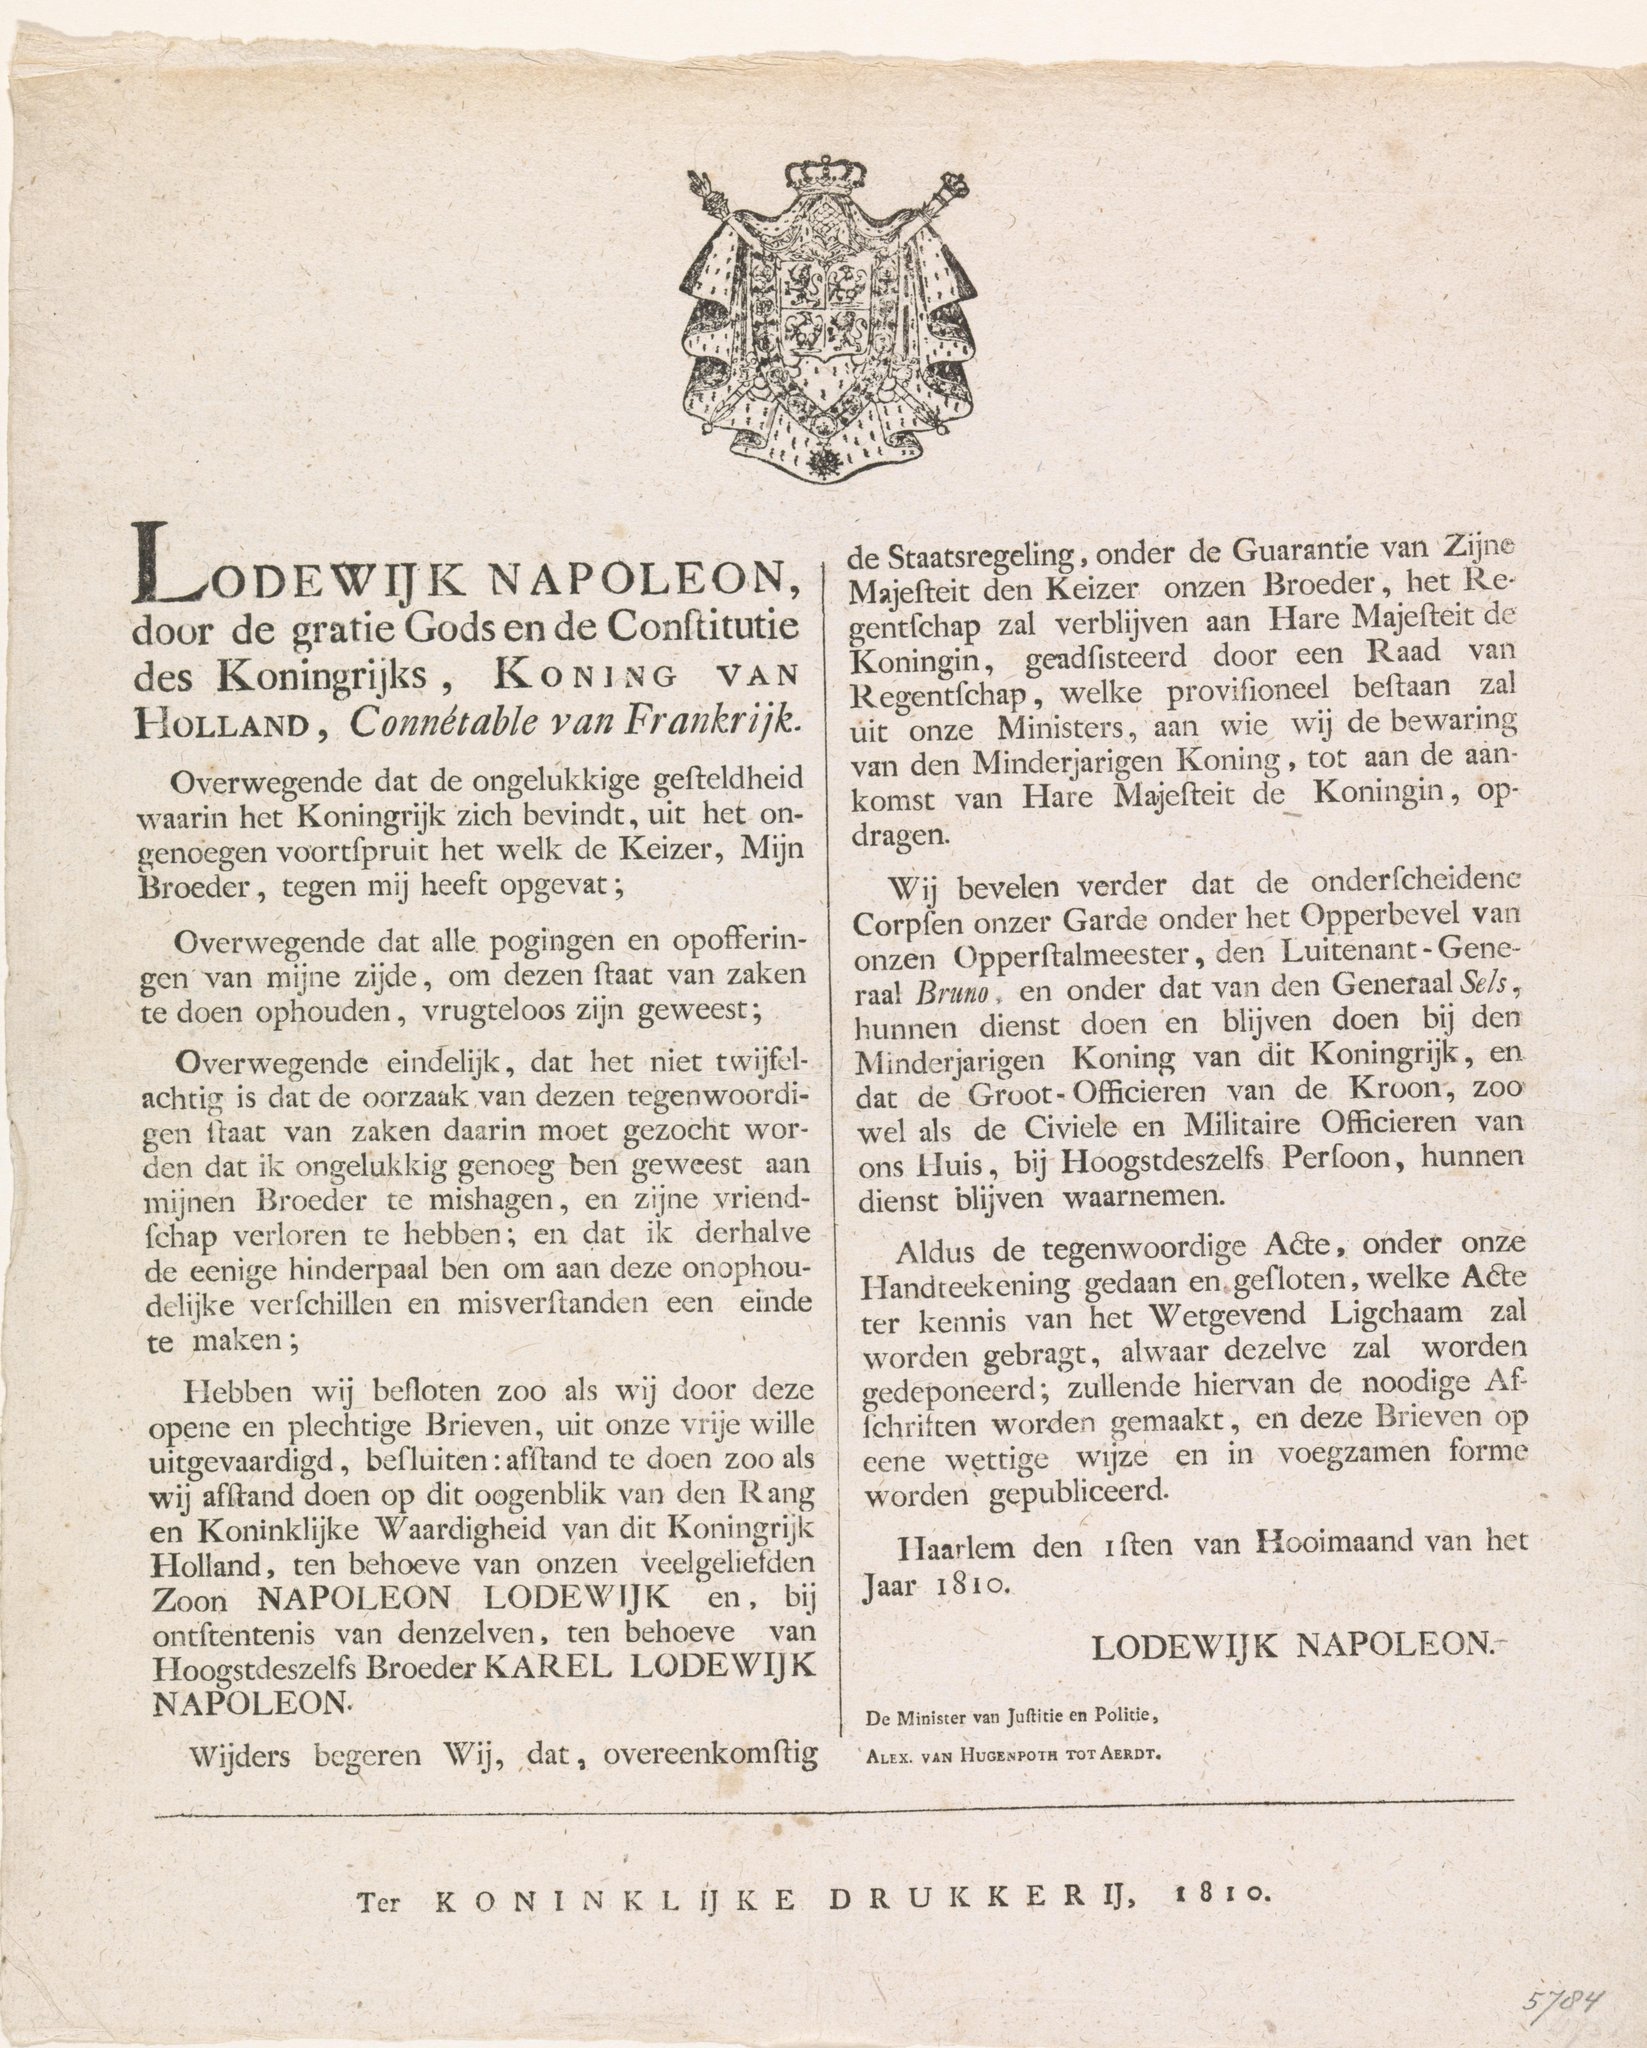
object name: text sheet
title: Acte waarin Lodewijk Napoleon afstand doet van de troon, 1810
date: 1807-1810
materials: paper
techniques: letterpress printing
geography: netherlands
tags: louis napoleon (king of holland), paris, haarlem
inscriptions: collector's mark: Lugt 2228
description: Officiële acte waarin Lodewijk Napoleon als koning van Holland afstand doet van de troon, ten gunste van zijn zoon Napoleon Lodewijk, 1 juli 1810. Tekst in twee kolommen, bovenaan het koninklijk wapen.